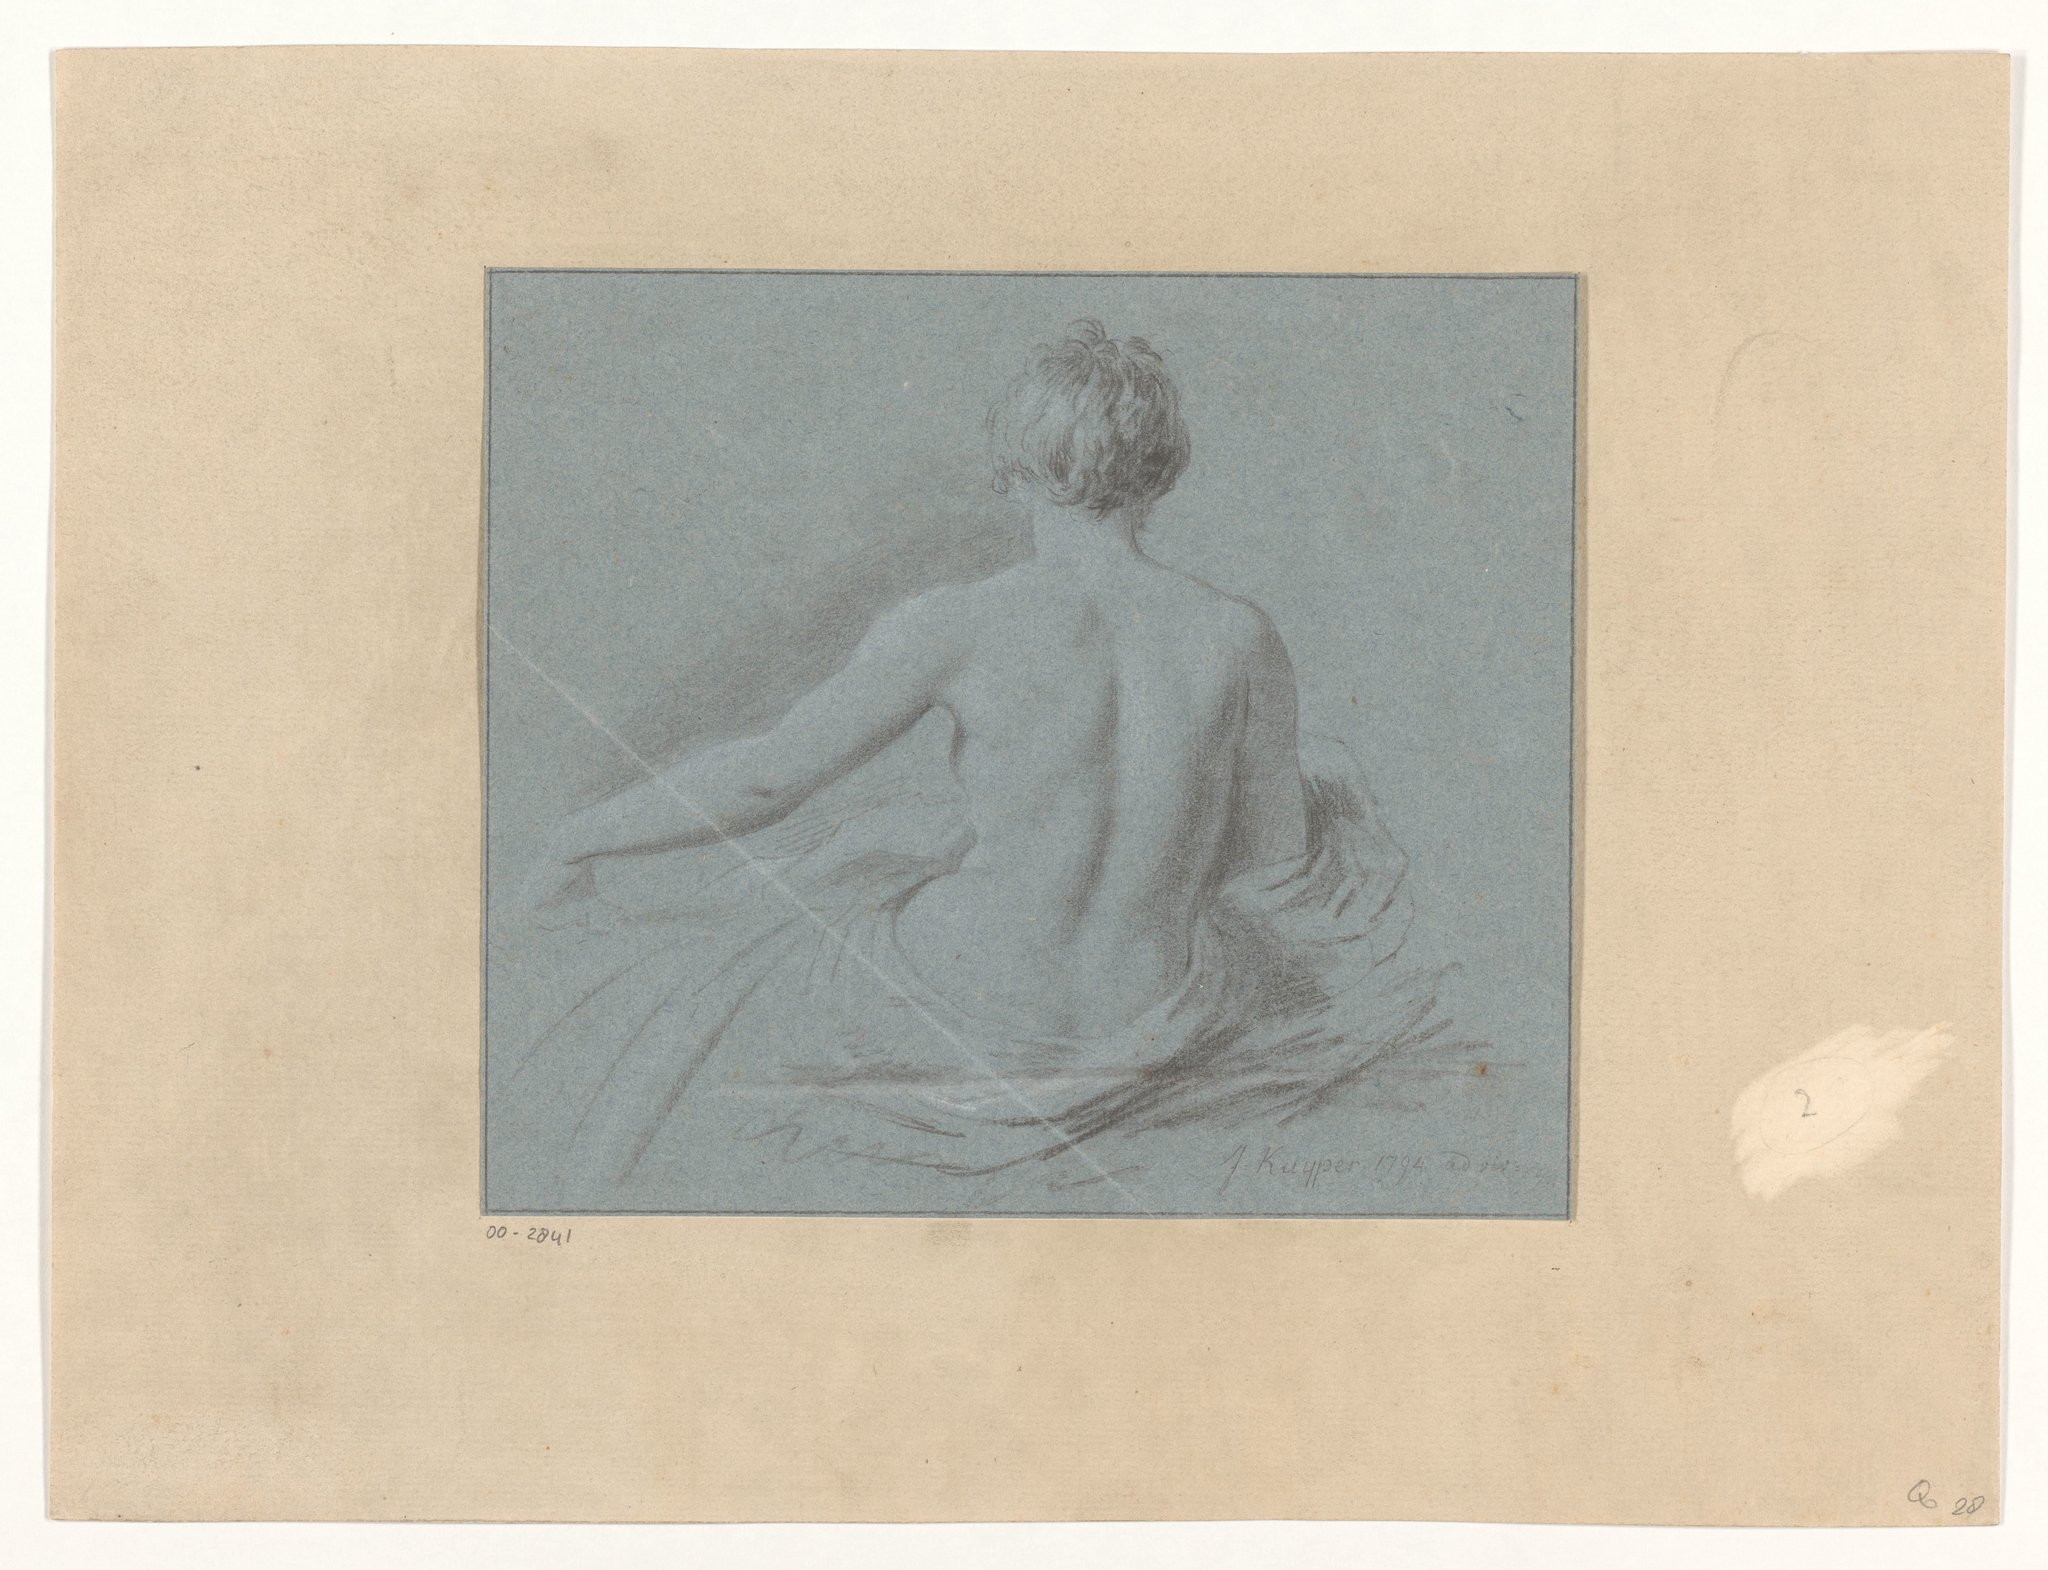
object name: drawing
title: Zittend vrouwelijk naakt, op de rug gezien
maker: jacques kuyper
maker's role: draughtsman, print maker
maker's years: 1761-1808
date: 1794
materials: chalk, charcoal, paper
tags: sitting figure - aa - female human figure (+ nude human being)